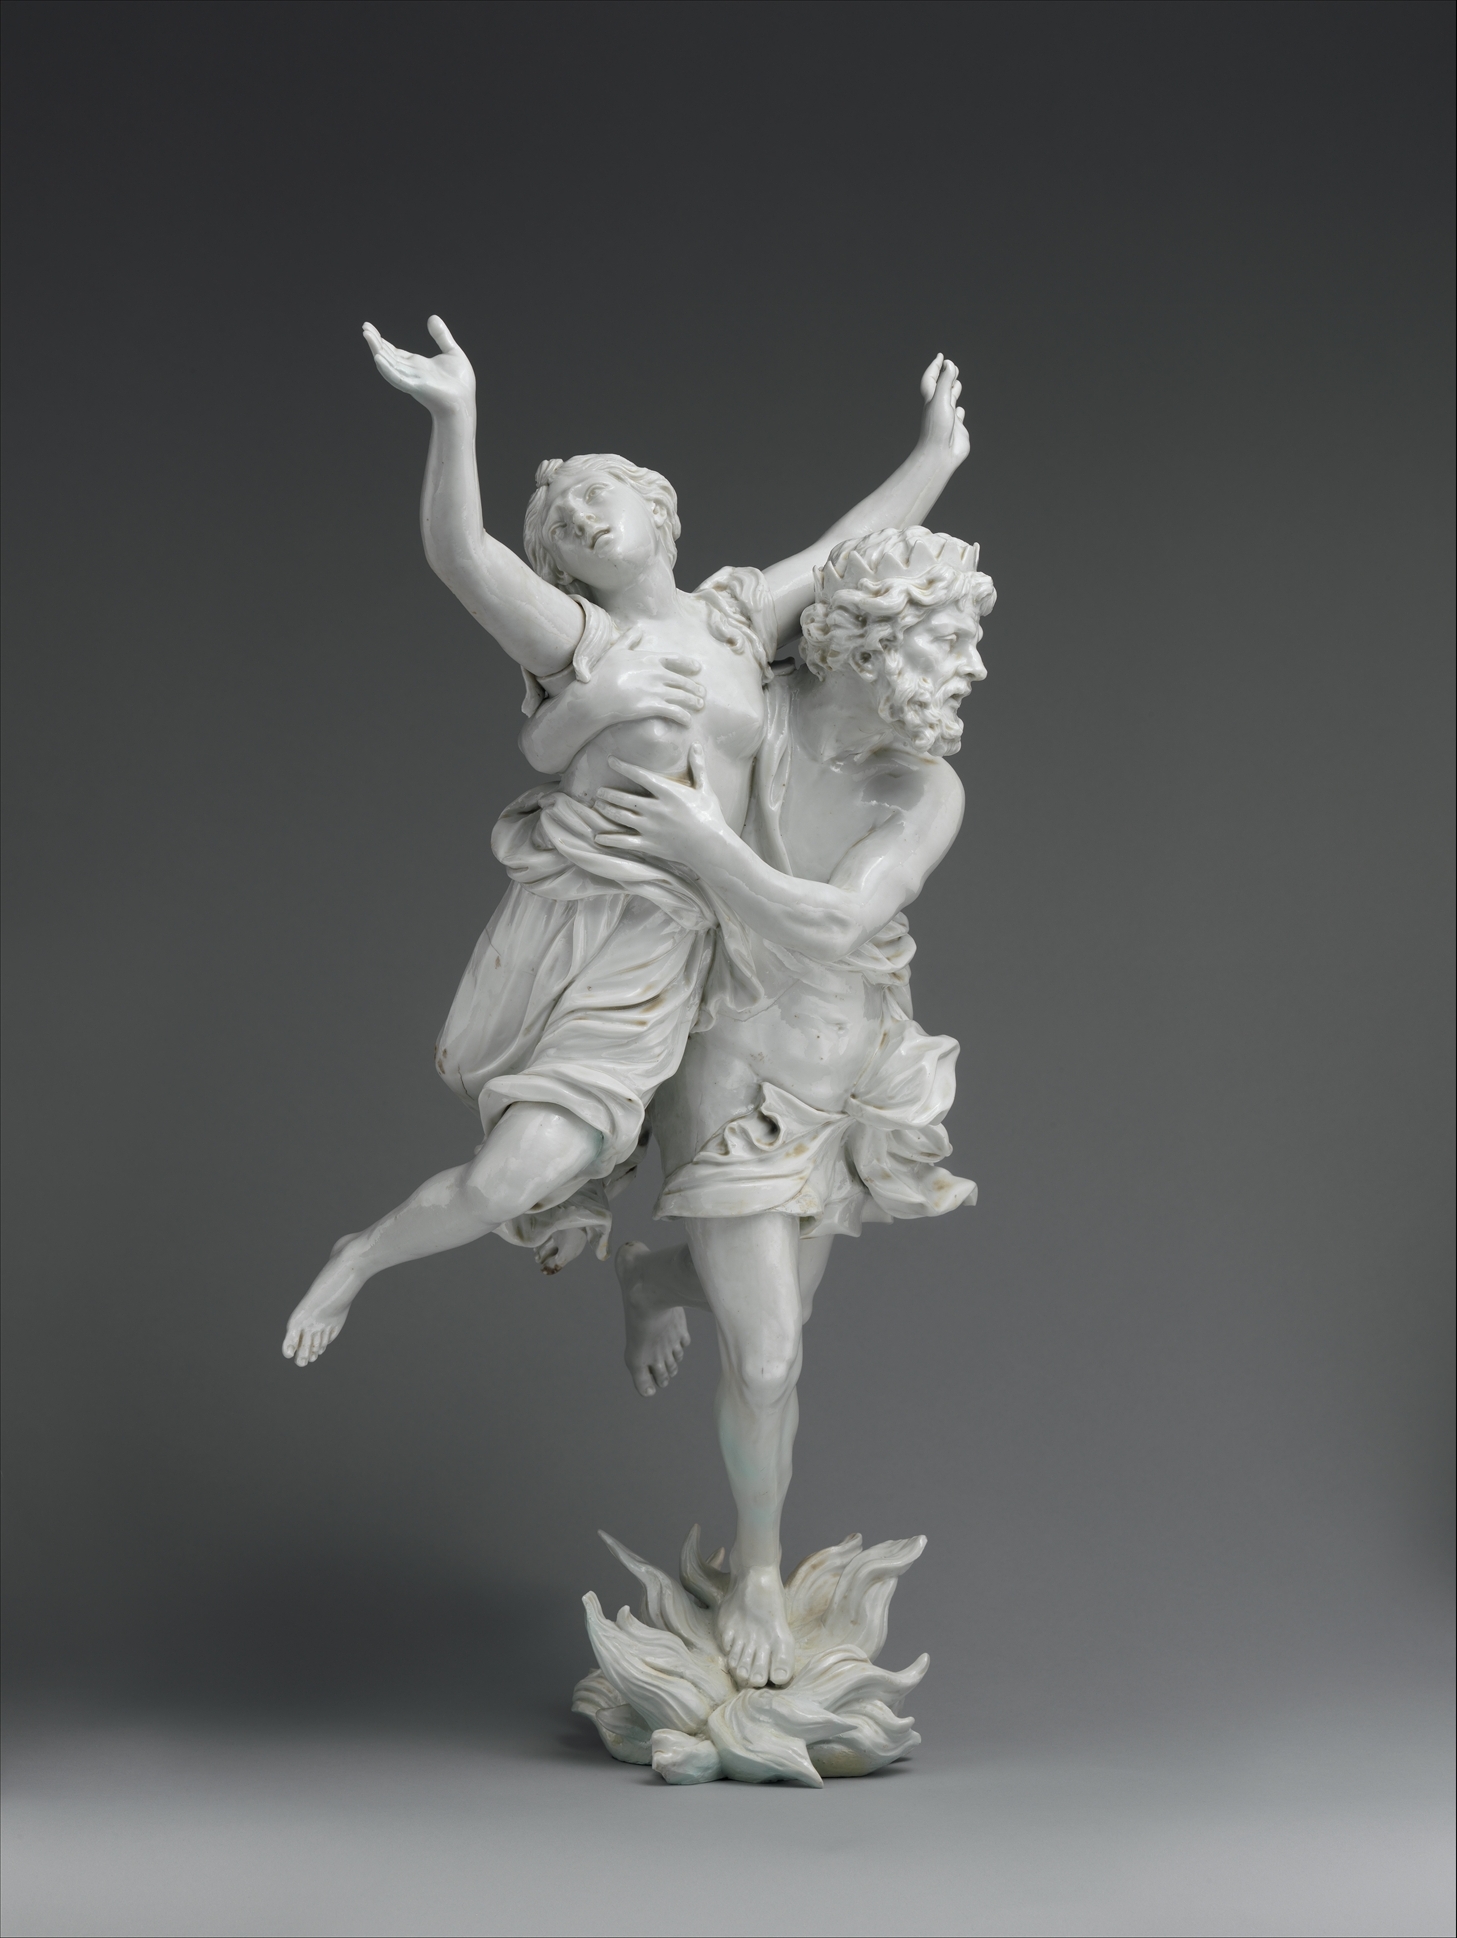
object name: group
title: Rape of Proserpina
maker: doccia porcelain manufactory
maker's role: manufactory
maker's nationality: italian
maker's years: 1737-1896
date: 1750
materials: hard paste porcelain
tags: mythology,men,women,goddess